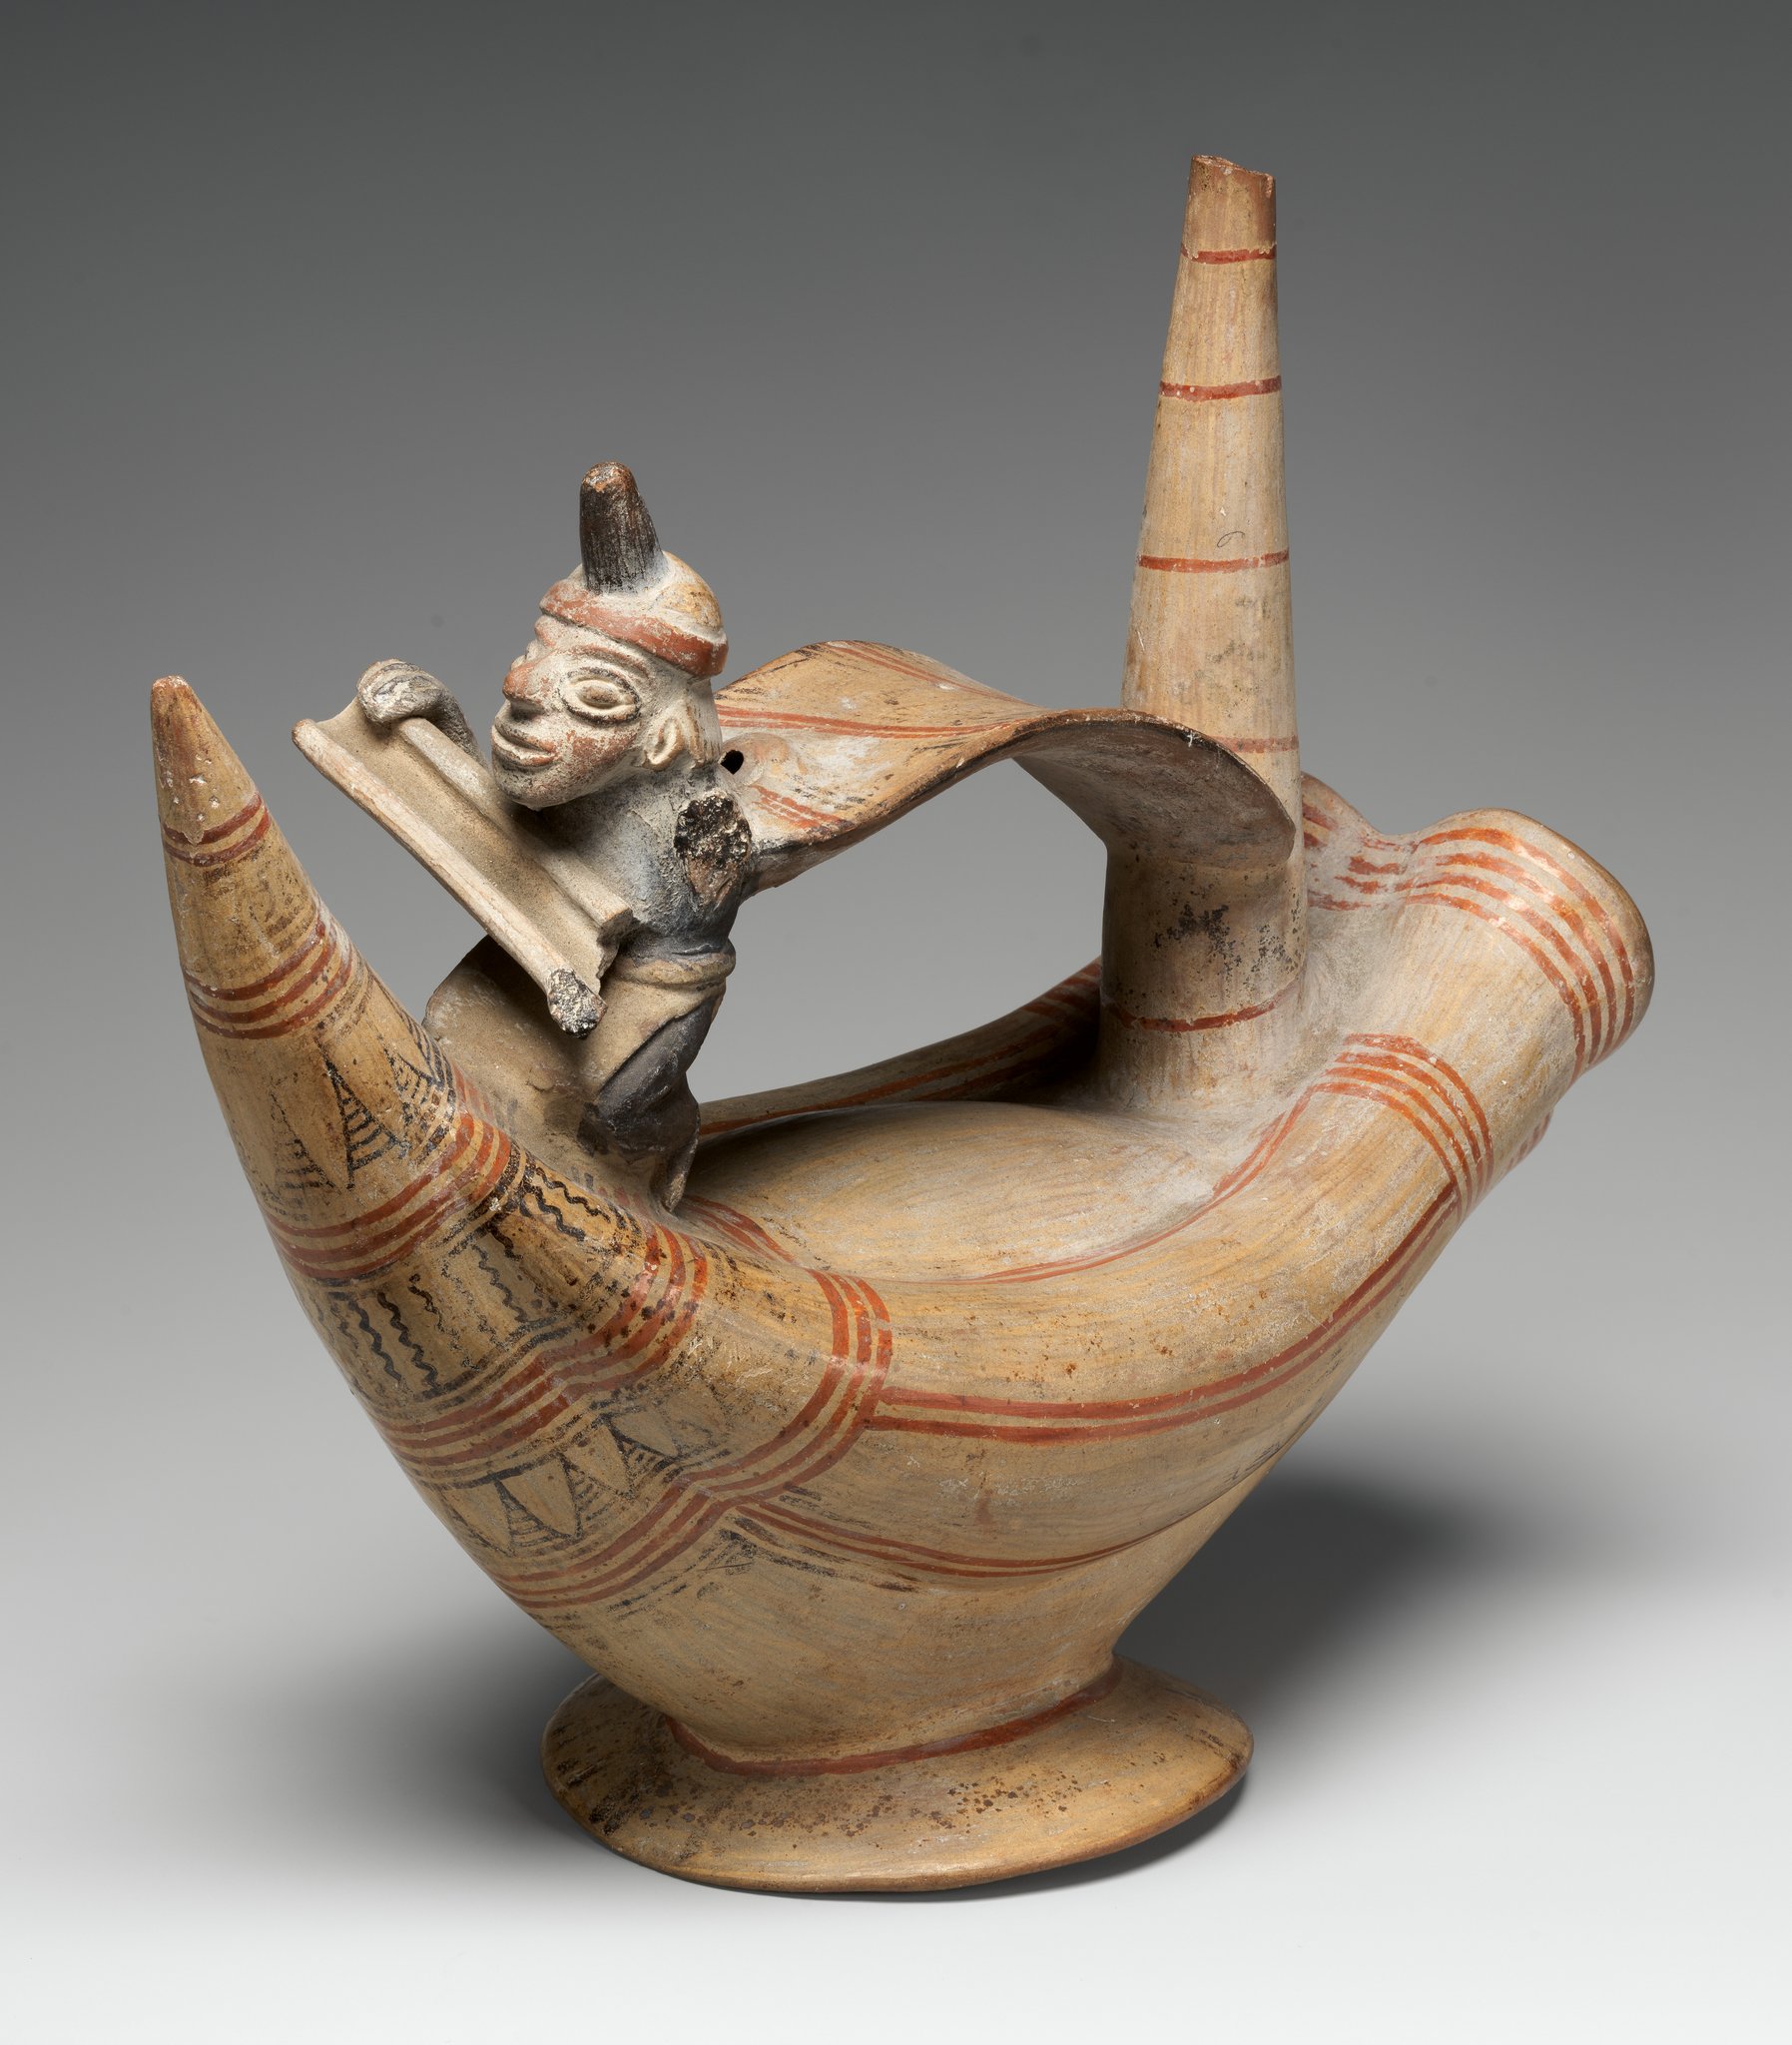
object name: bottle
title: Bottle with a reed boat and paddler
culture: lambayeque, sicán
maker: lambayeque (sicán) artist(s)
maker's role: artist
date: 900-1375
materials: ceramic, pigment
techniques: firing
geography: peru